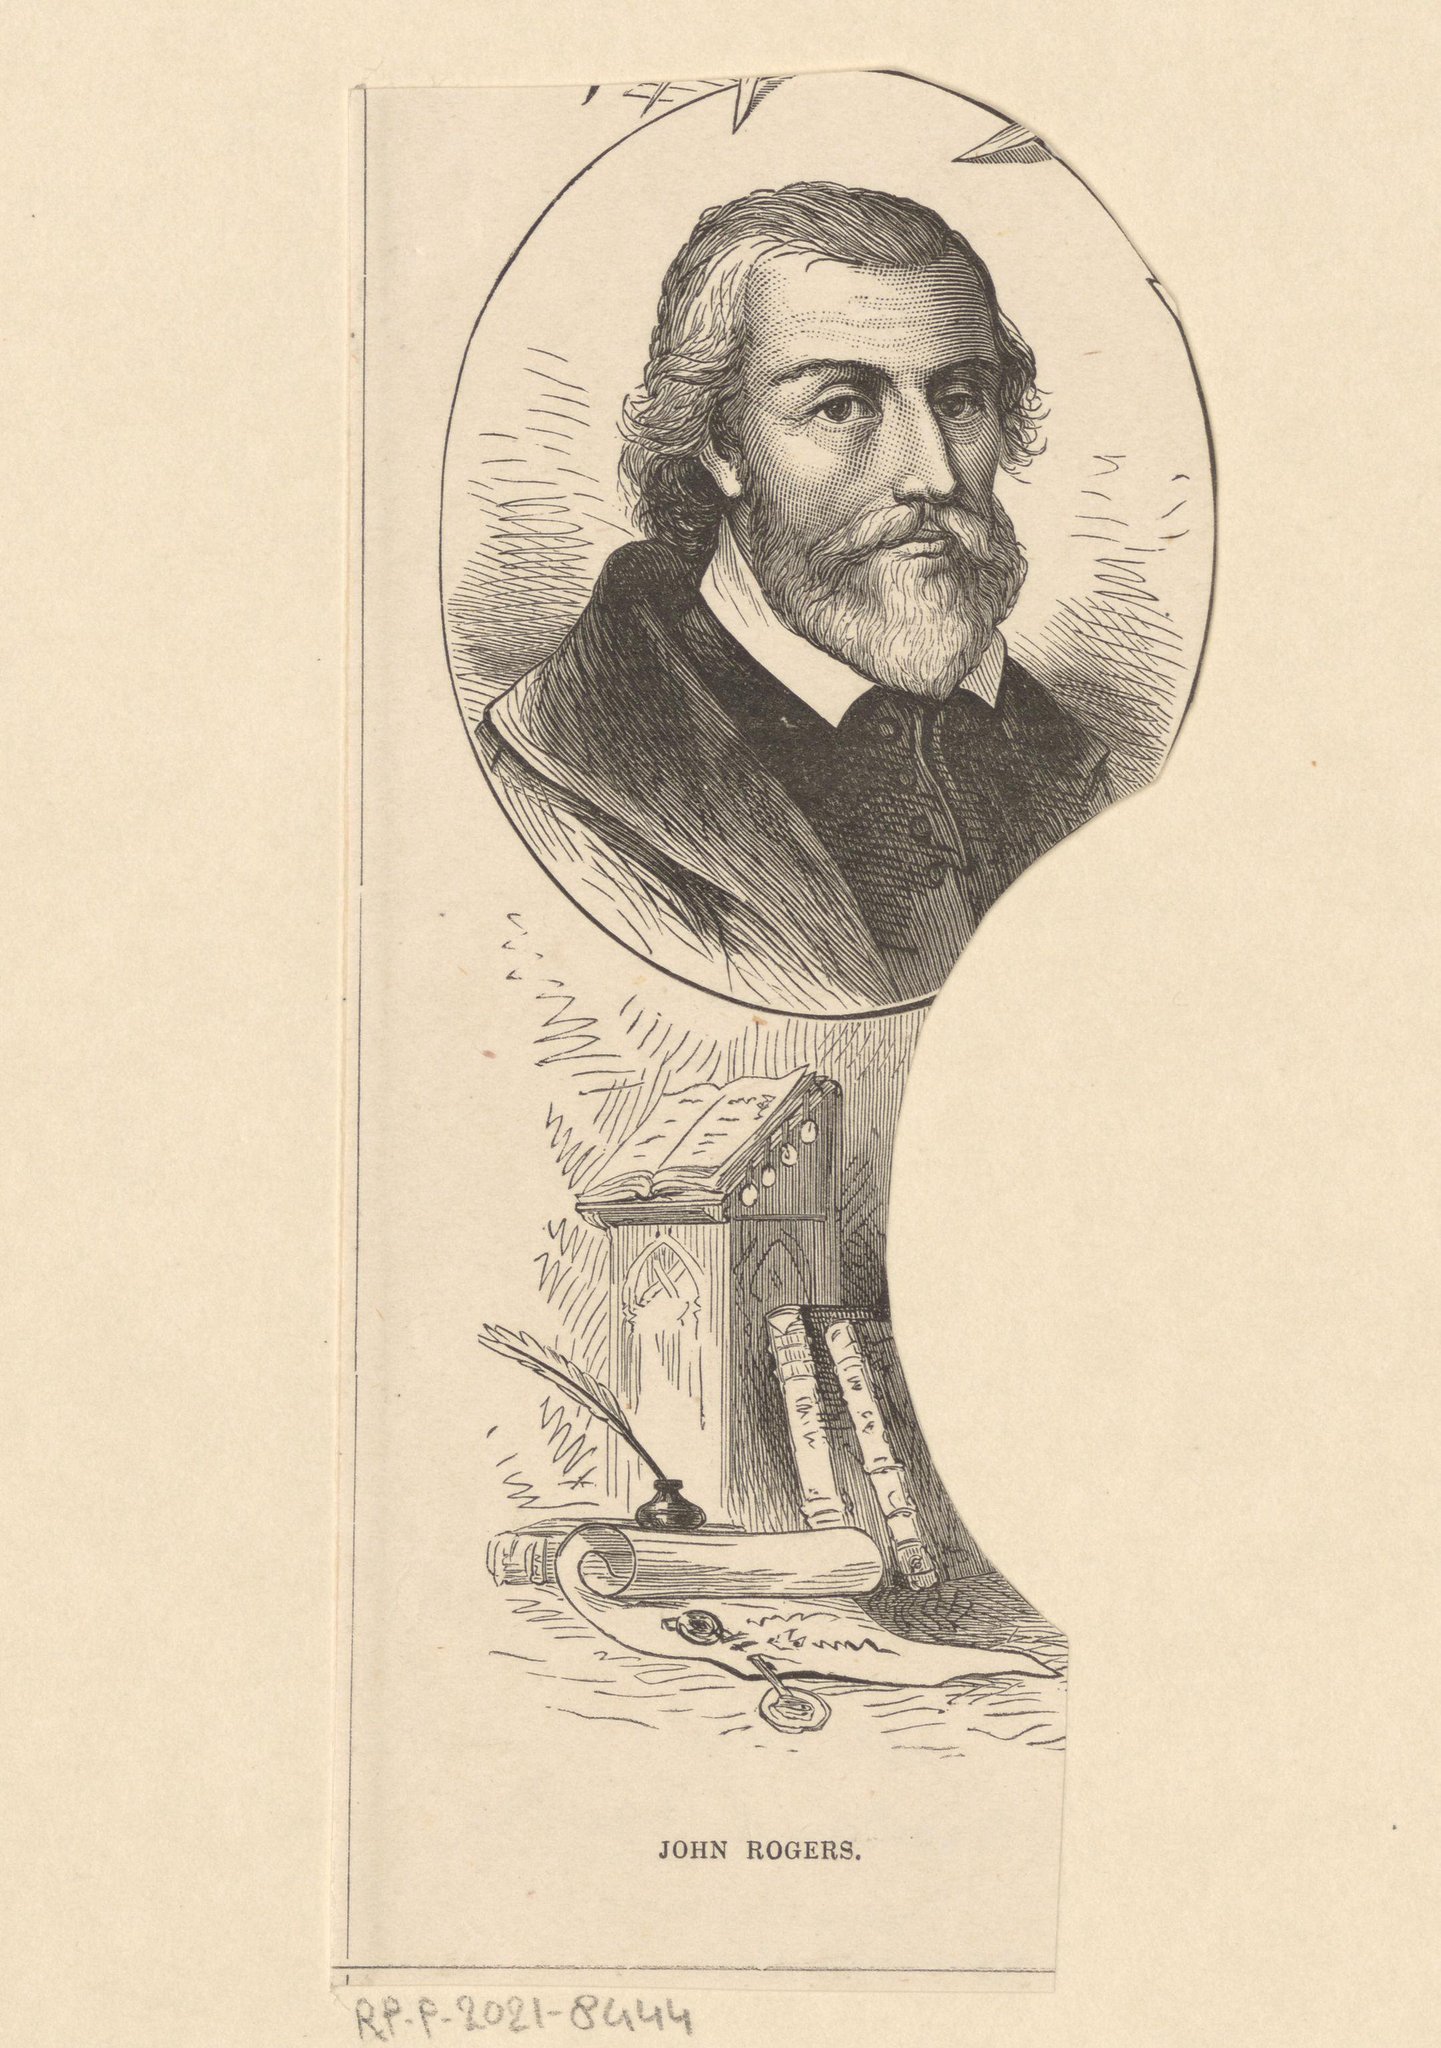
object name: print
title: Portret van John Rogers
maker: Anonymous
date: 1800-1899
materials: paper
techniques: engraving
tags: historical persons, book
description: Prent geknipt uit een blad met meerdere portretten.